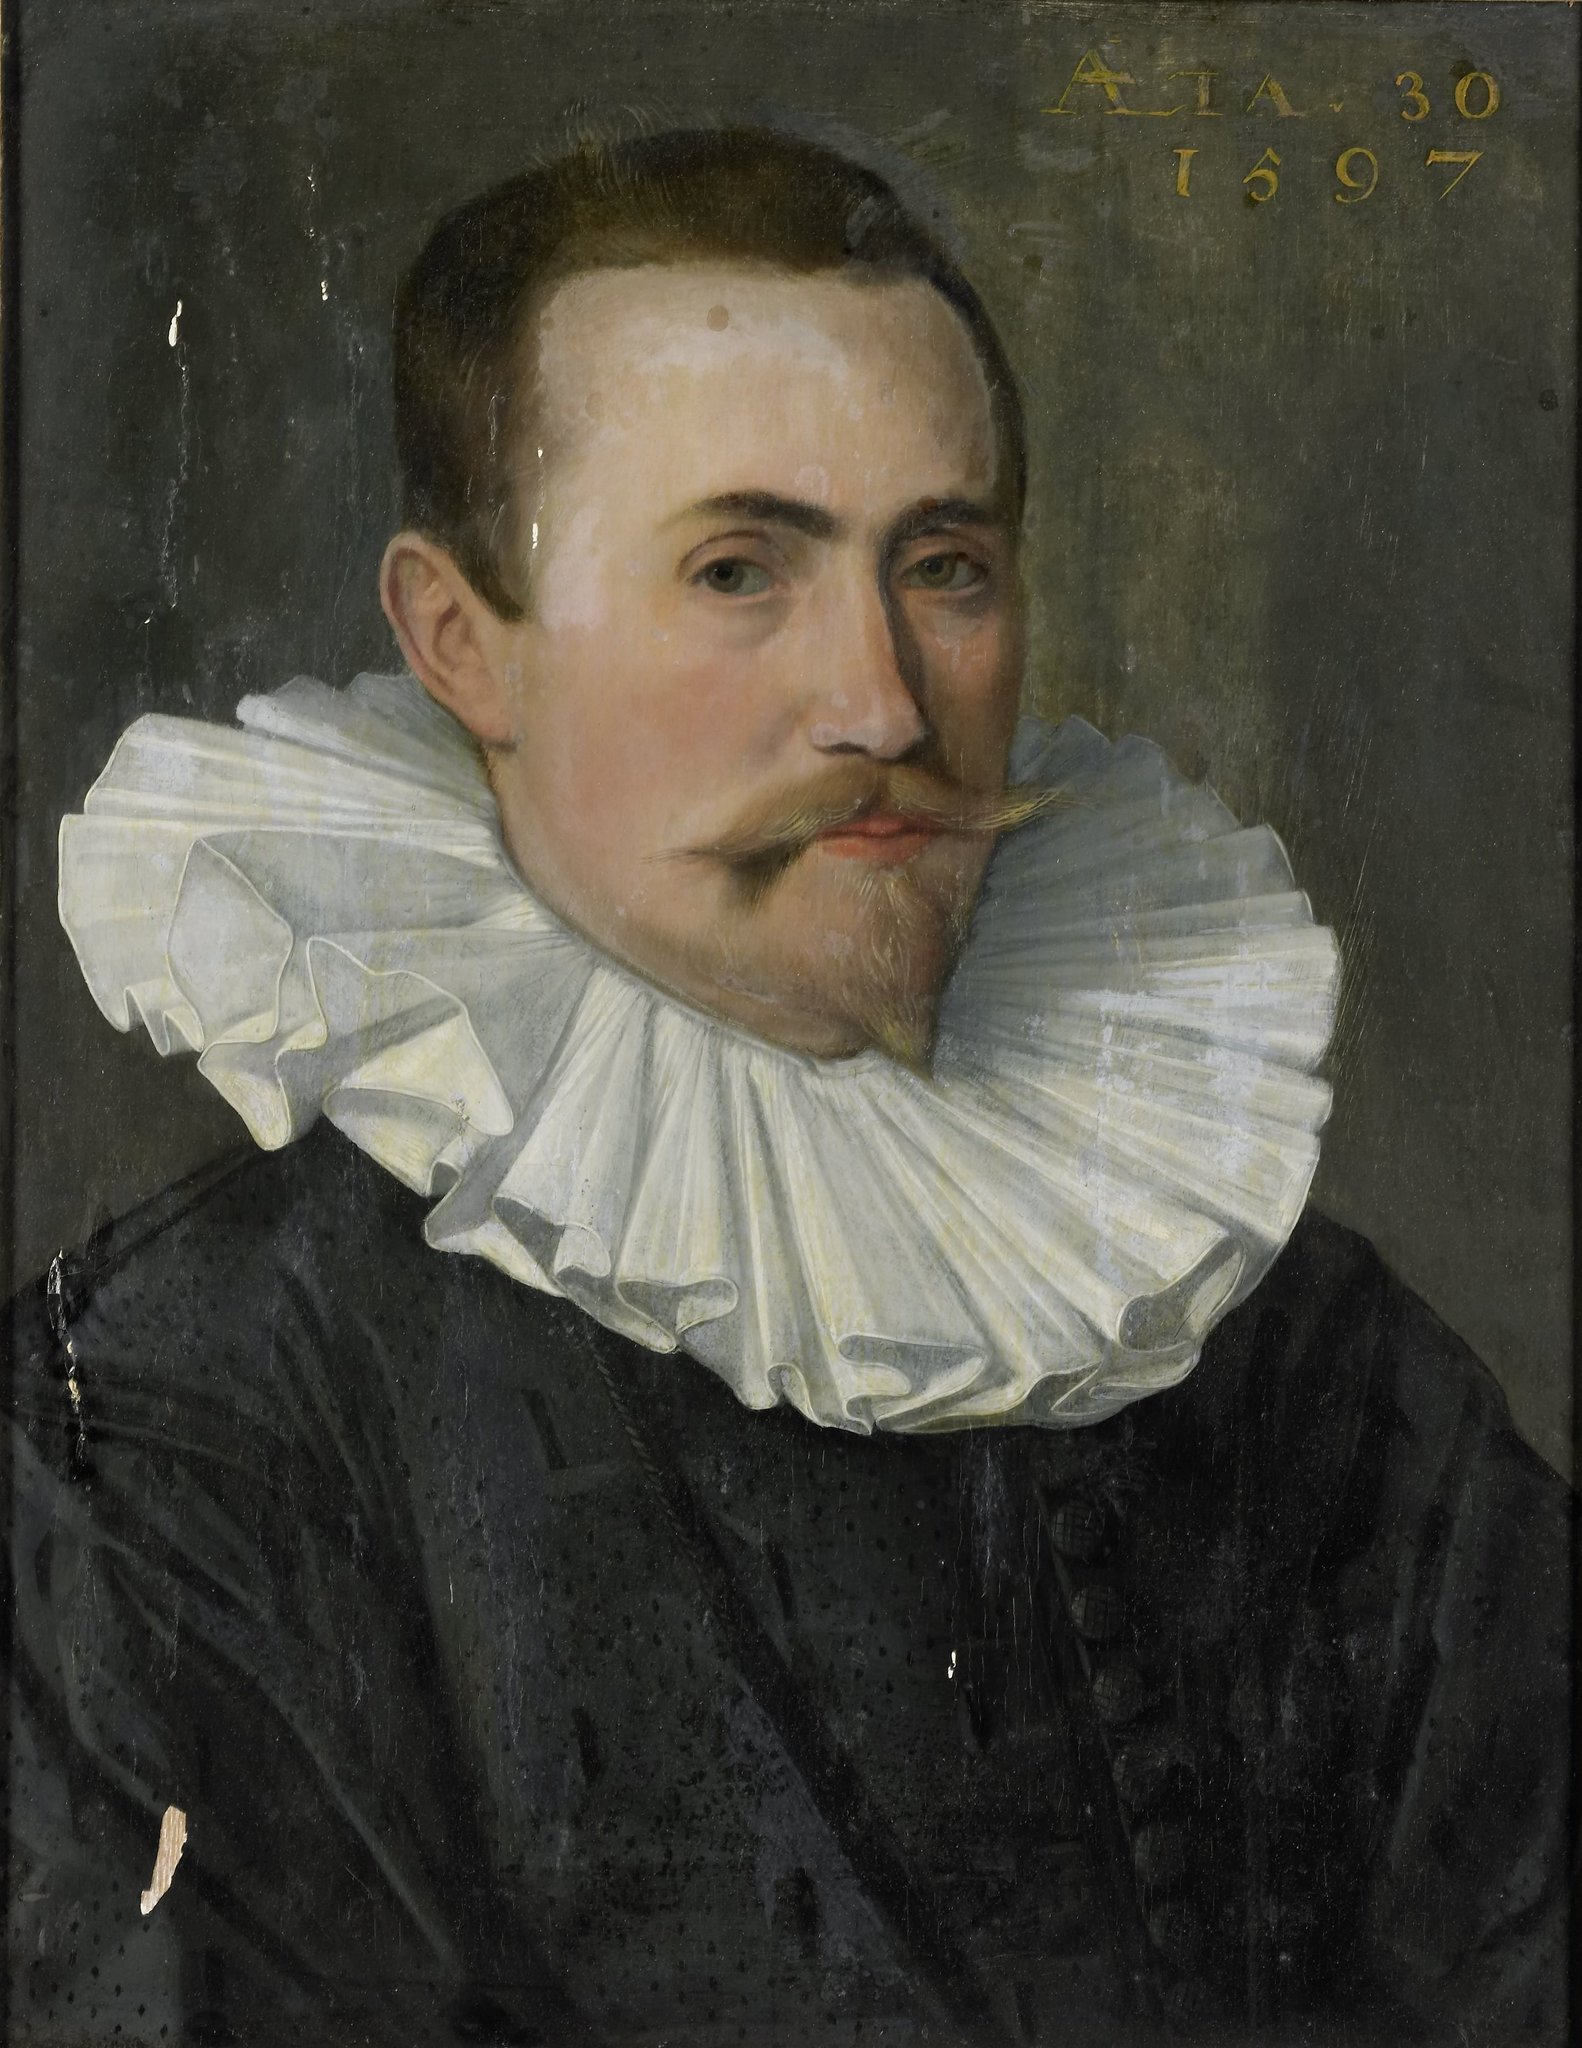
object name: painting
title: Portrait of a Man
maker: Anonymous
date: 1597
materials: oil, panel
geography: netherlands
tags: neck-gear: collar, historical persons not known by name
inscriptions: inscription and date: ‘AEta. 30 1597’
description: Portret van een dertigjarige man, buste naar rechts.